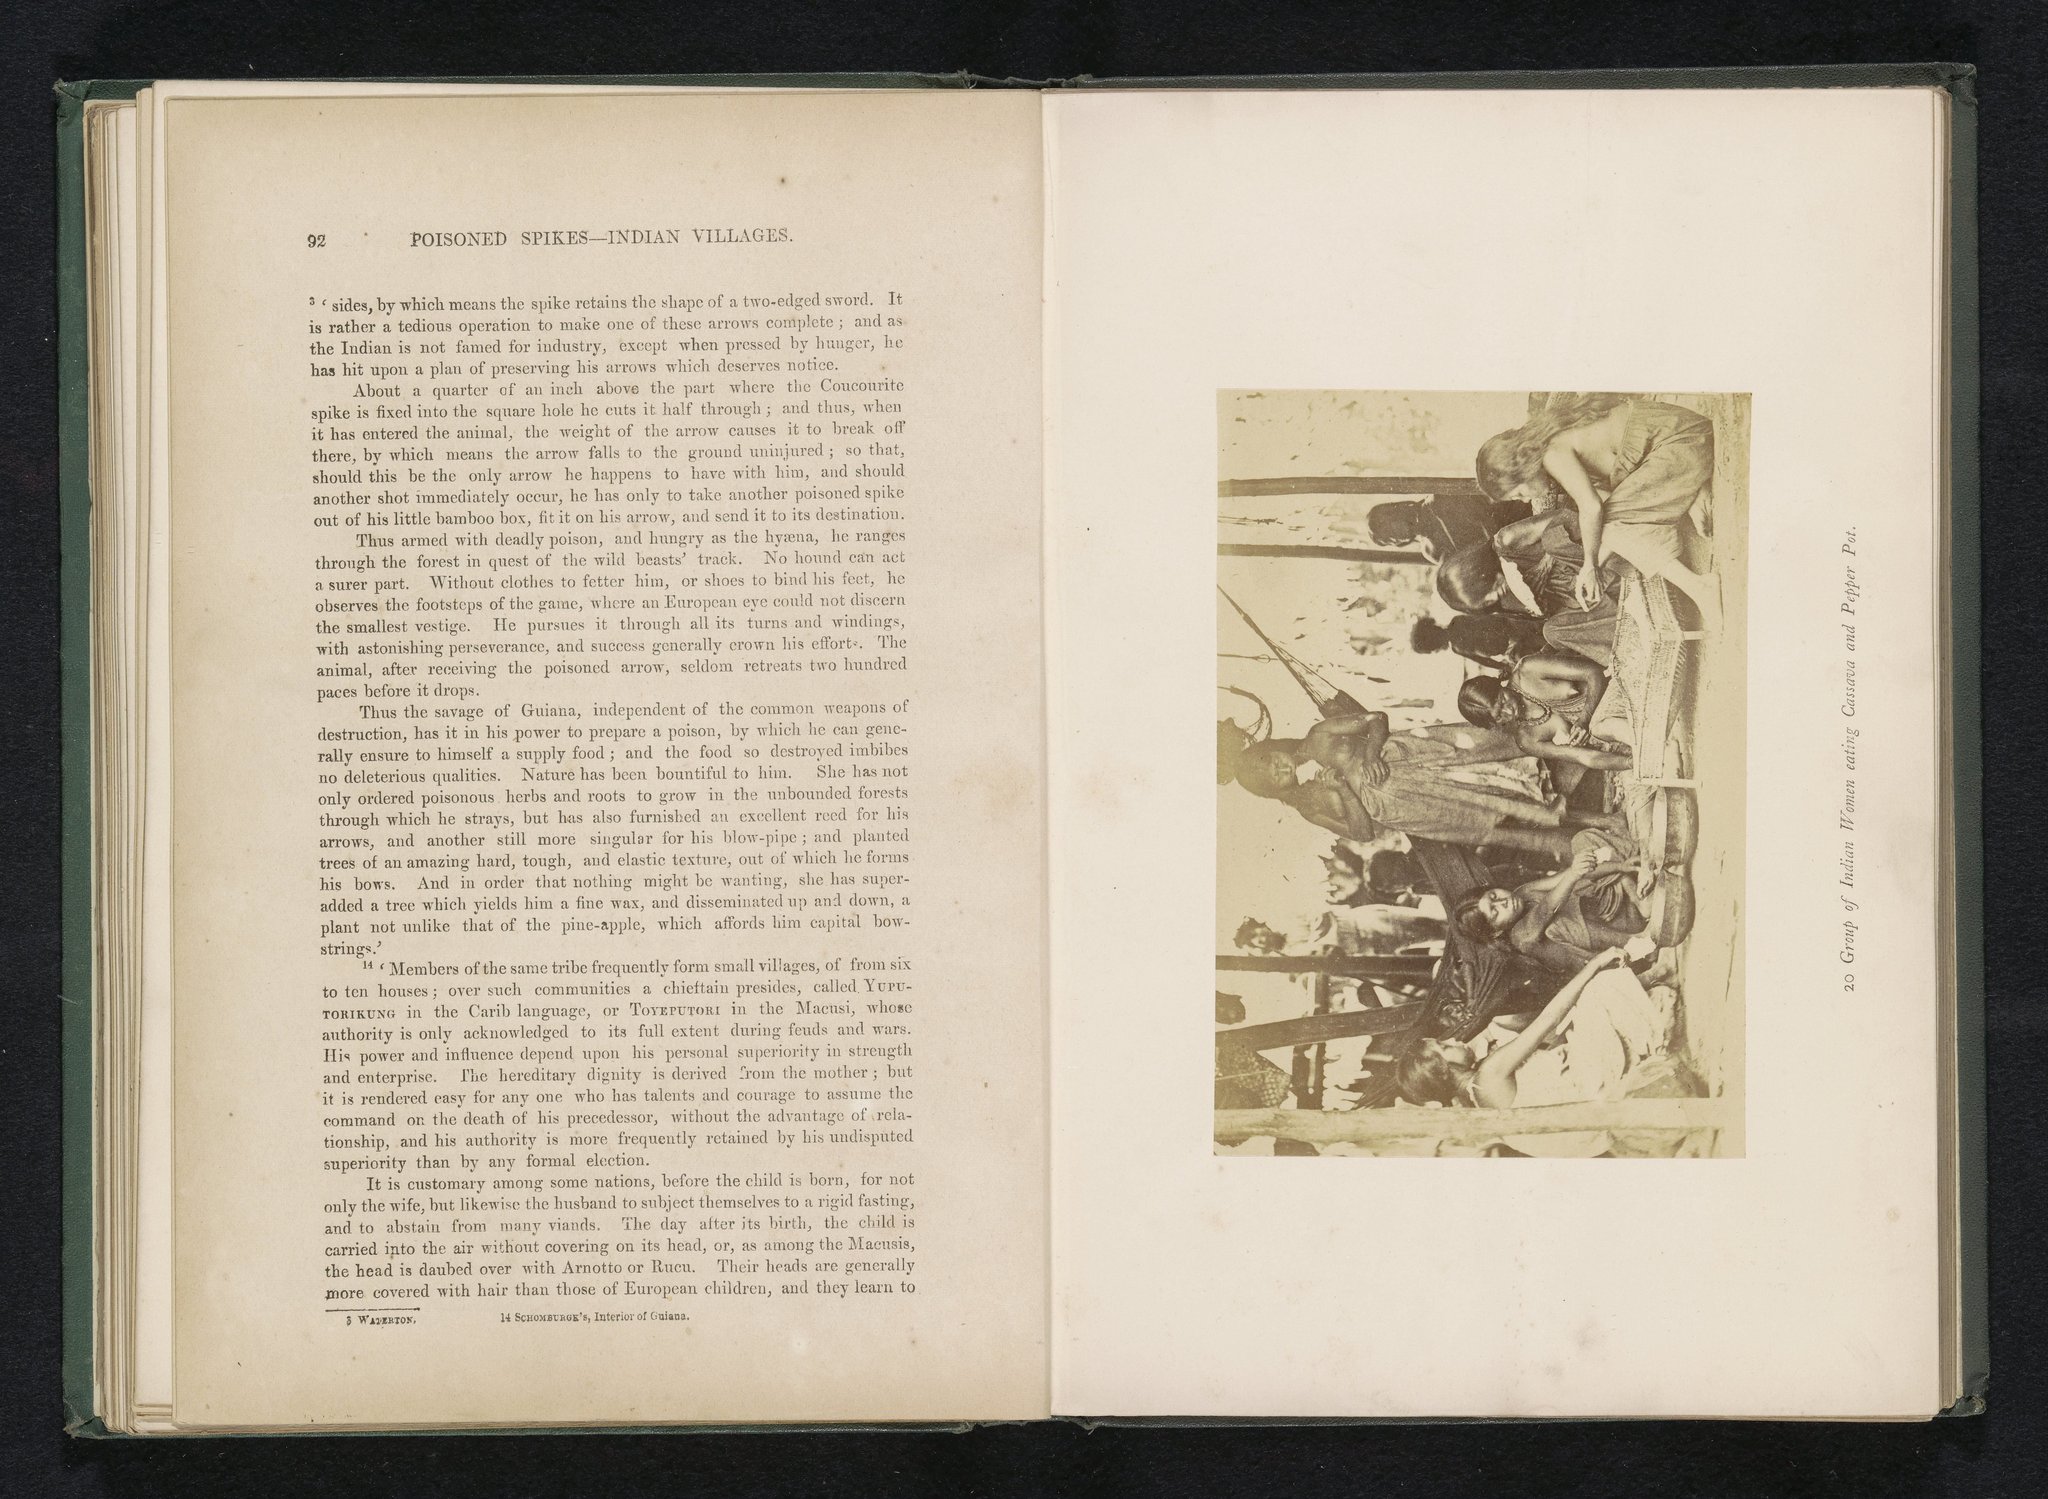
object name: photograph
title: Group of Indian Women eating Cassava and Pepper Pot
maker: Anonymous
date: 1856-1866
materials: photographic support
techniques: albumen print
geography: guyana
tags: indigenous peoples of south america, cooking food, eating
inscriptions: number: ‘20’